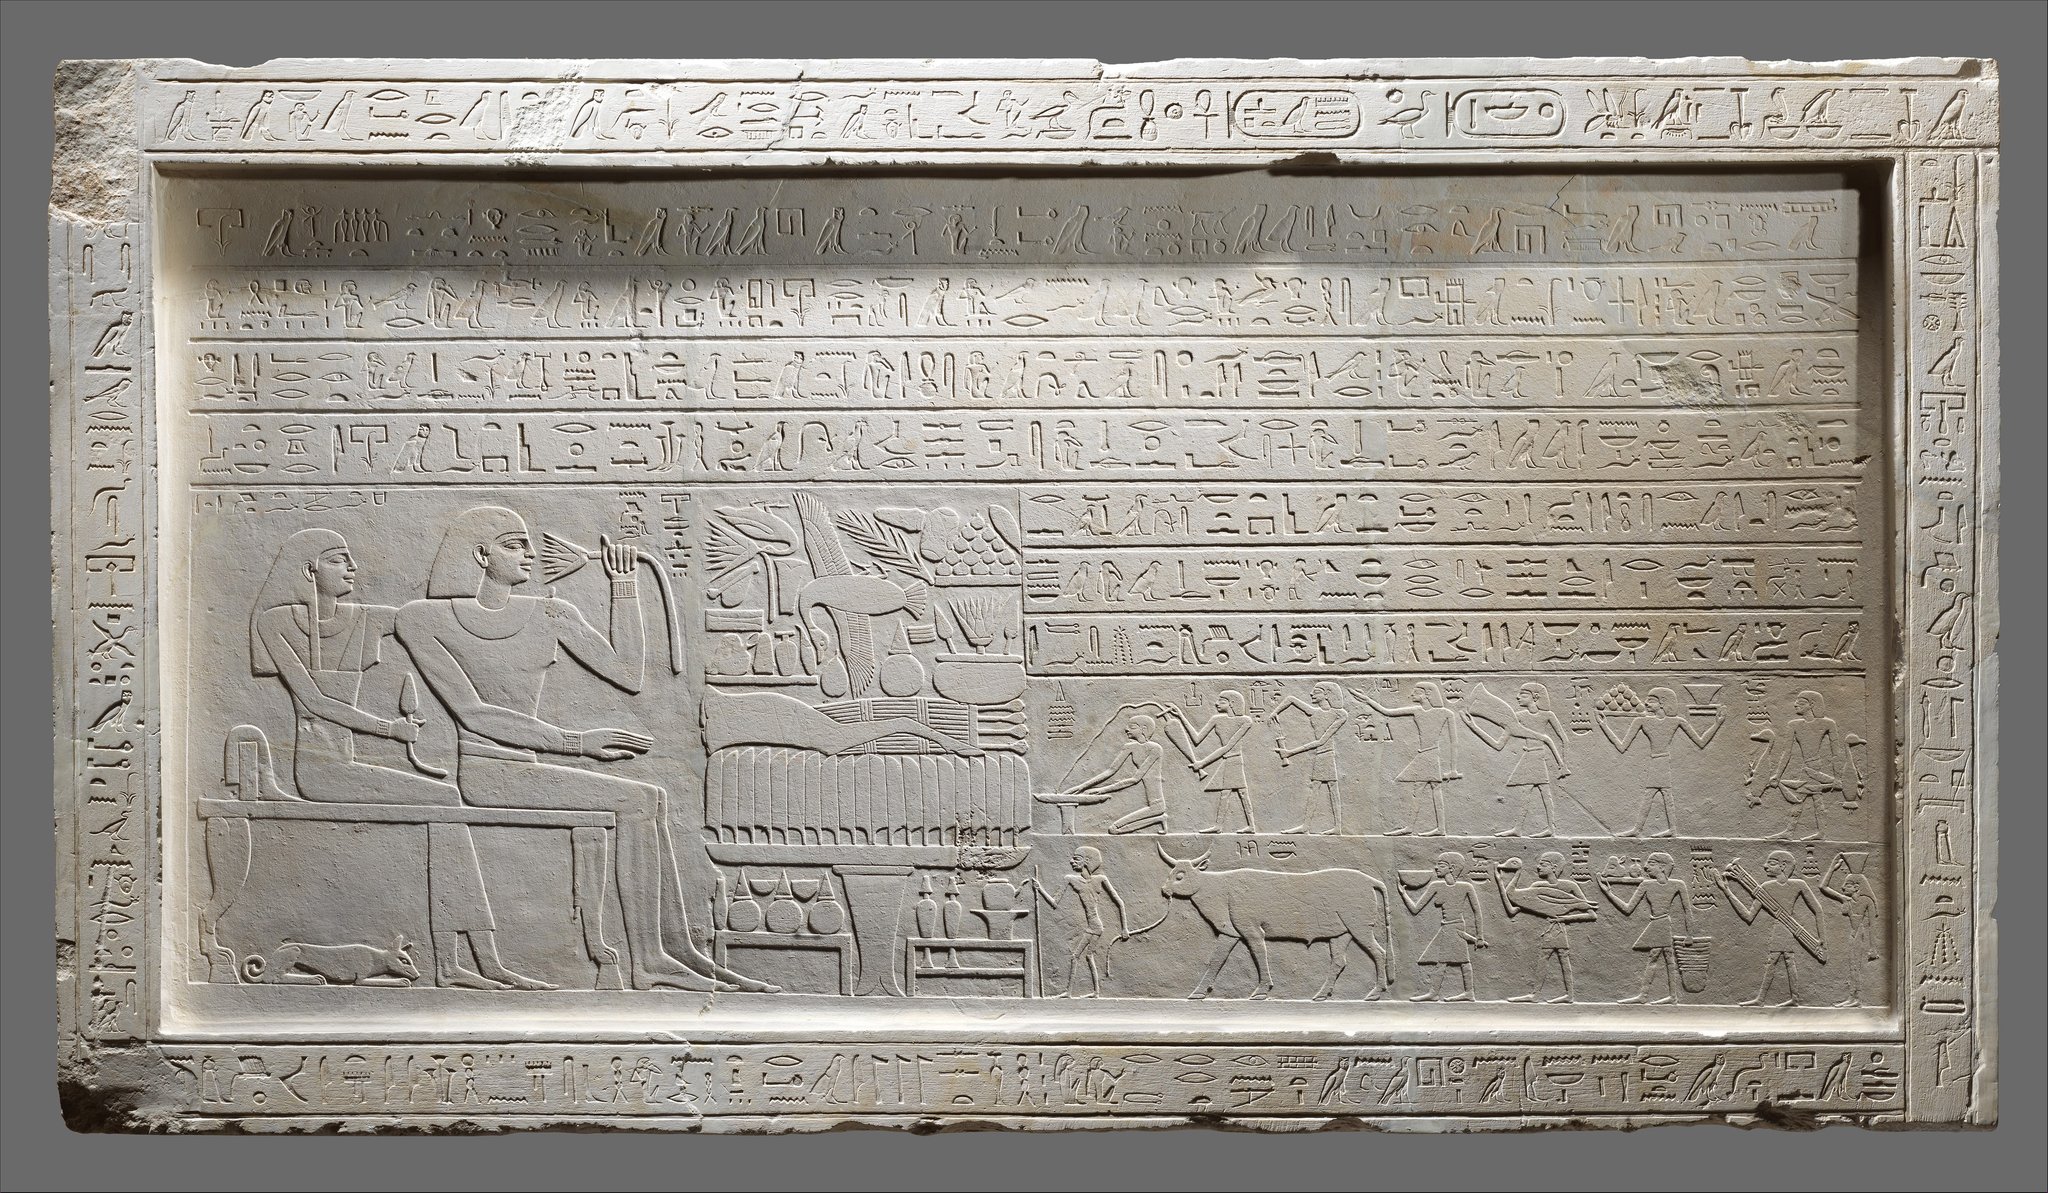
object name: stela, intef, iti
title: Stela of the Overseer of the Fortress Intef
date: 2000-1988 BCE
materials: limestone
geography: egypt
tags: human figures,animals,hieroglyphs